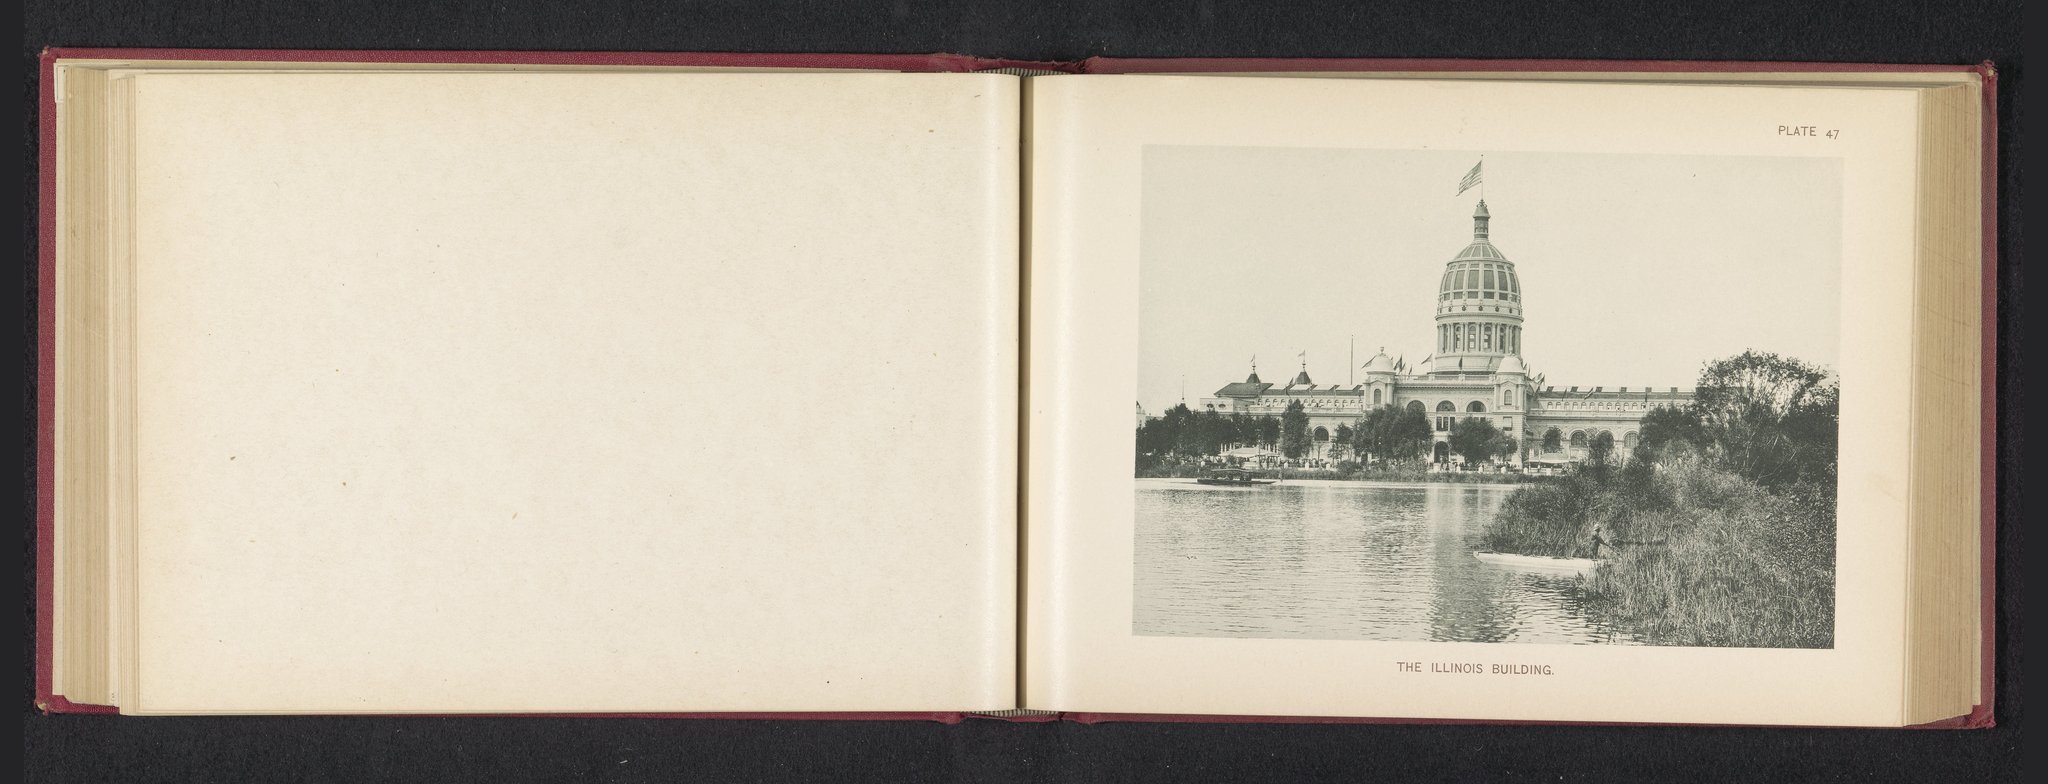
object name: photomechanical print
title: Gezicht op het Illinoisgebouw op de World's Columbian Exposition in Chicago in 1893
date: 1893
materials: paper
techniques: photograph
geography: chicago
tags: world fair, world exhibition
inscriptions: number: ‘Plate 47’